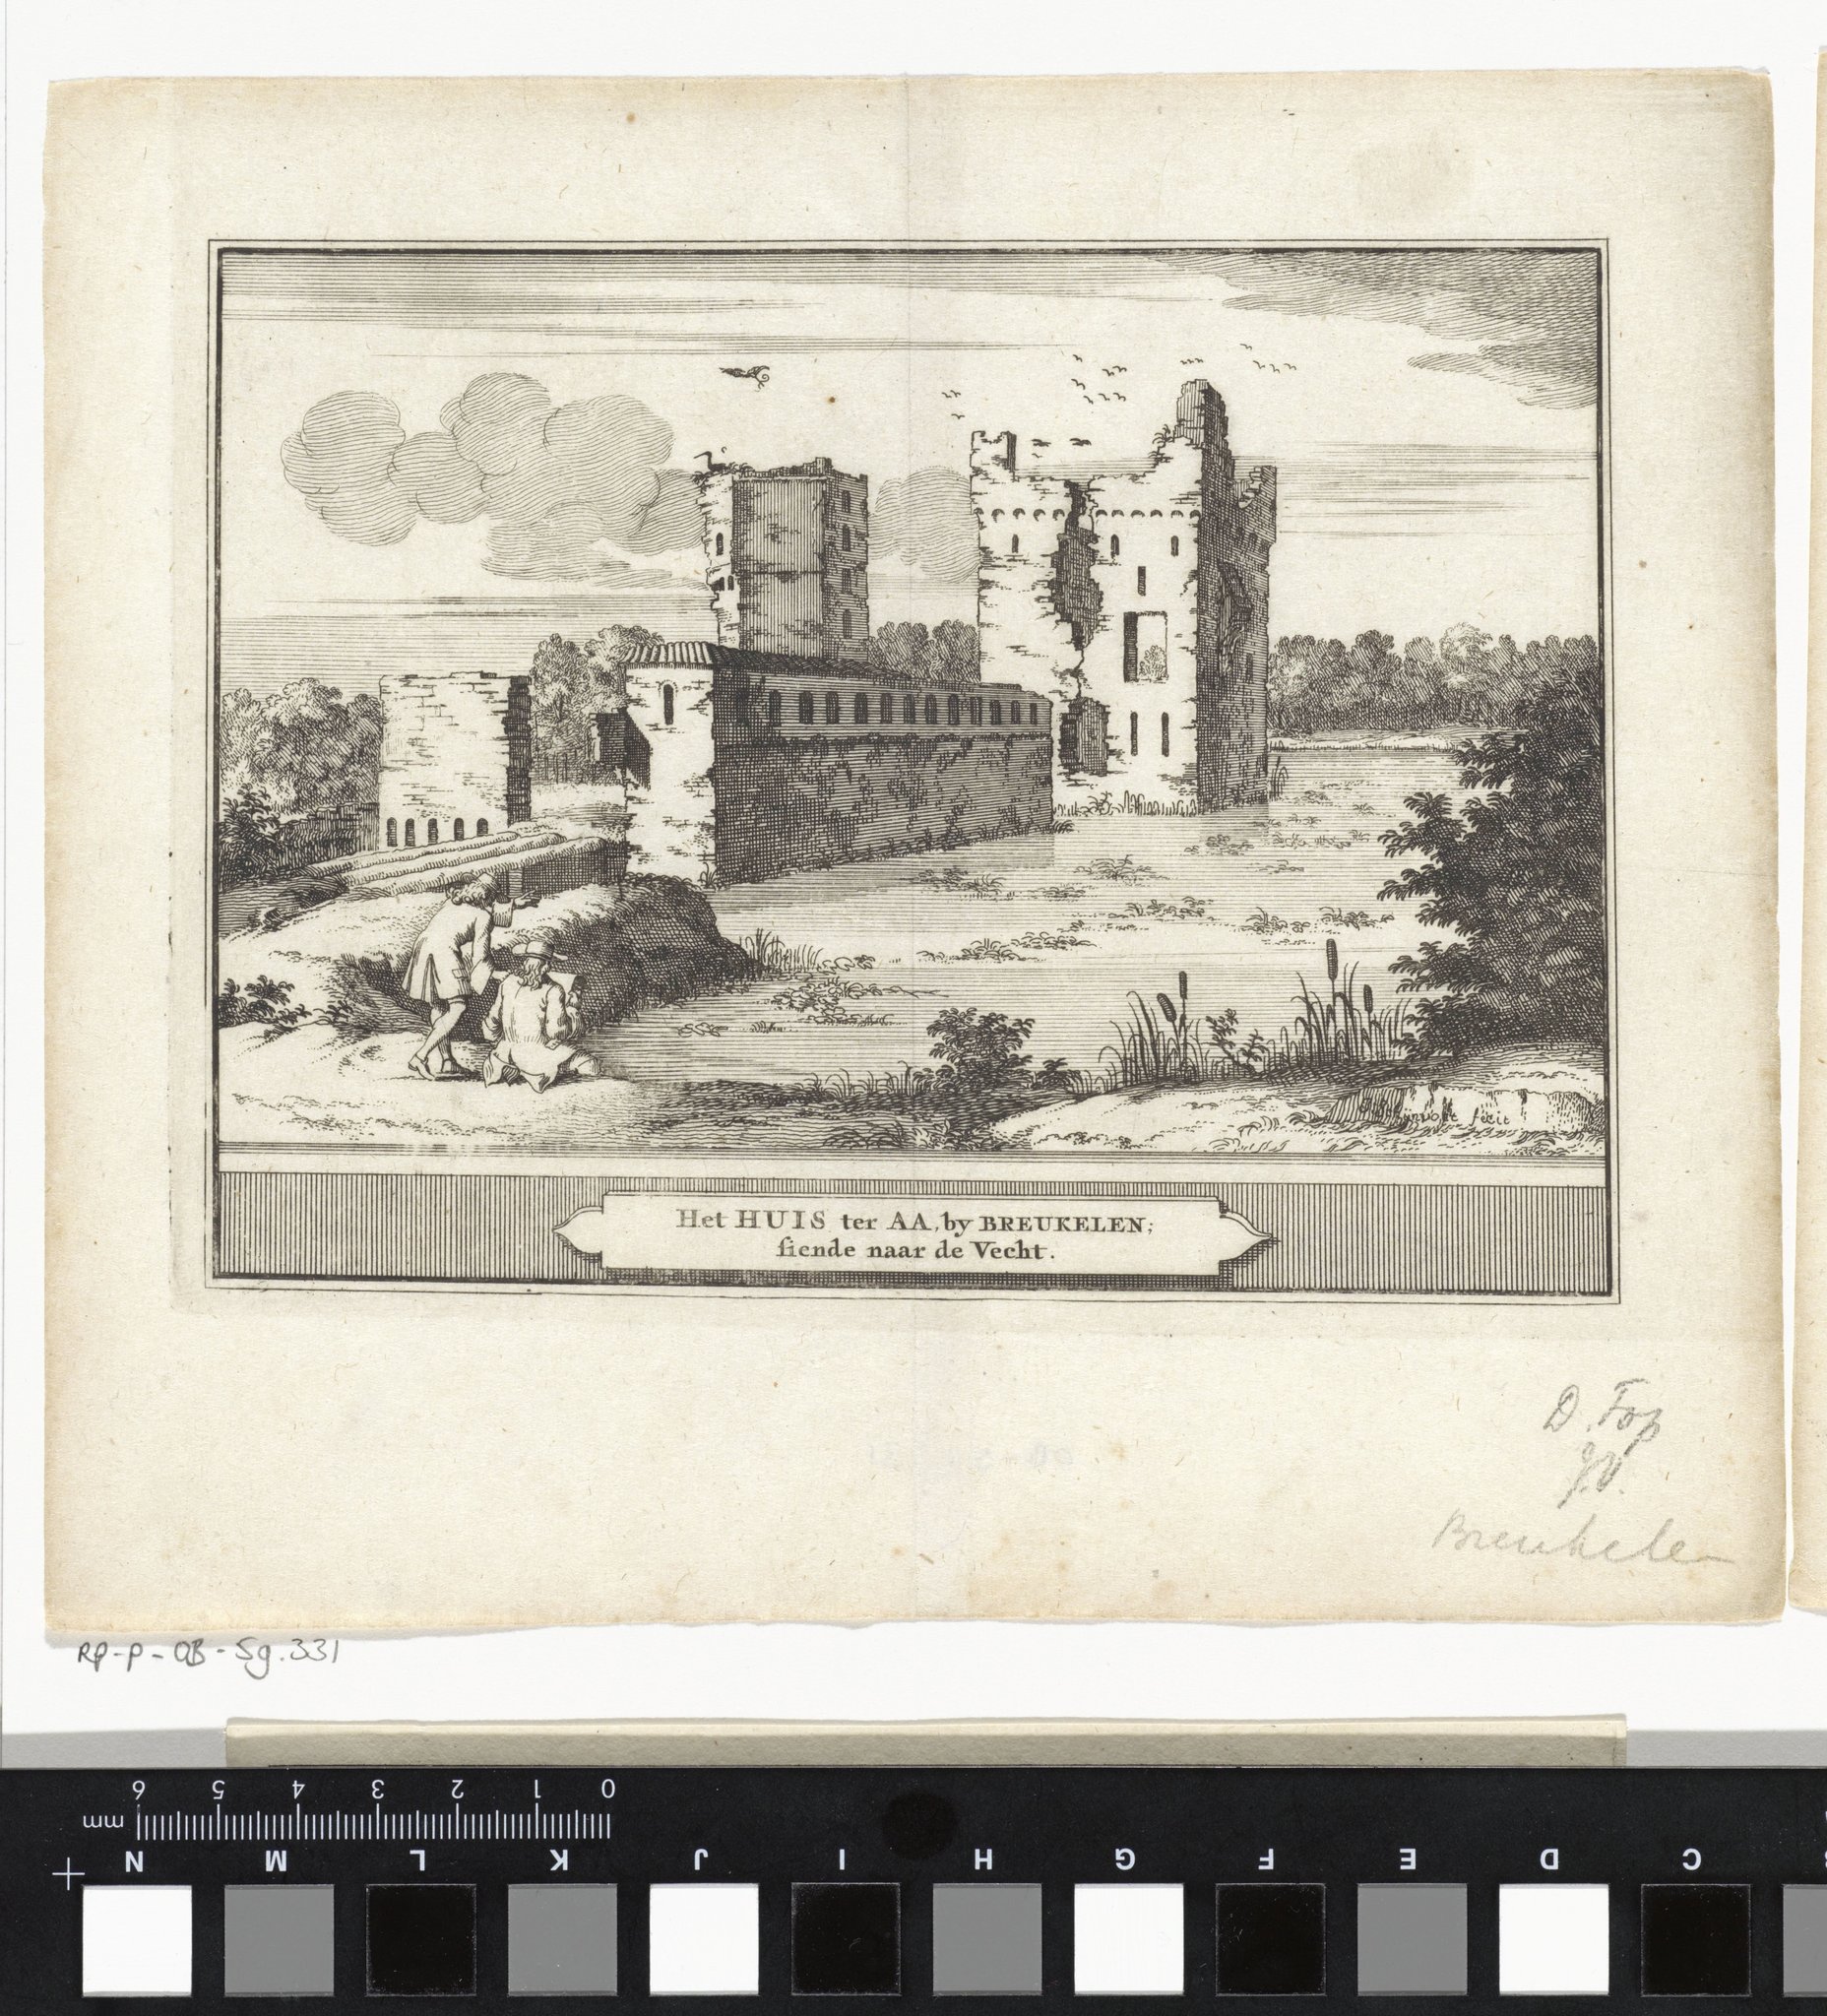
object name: print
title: Het huis ter Aa, by Breukelen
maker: jacobus schijnvoet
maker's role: draughtsman, print maker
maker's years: 1685-1743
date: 1711-1774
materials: paper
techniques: etching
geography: amsterdam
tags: castle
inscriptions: collector's mark: Lugt 2228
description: Prent als illustratie opgenomen in: Smids, Ludolph. Schatkamer der Nederlandsse[!] oudheden; of Woordenboek, behelsende Nederlands steden, Amsterdam: Pieter de Coup, 1711. Verscheen tevens in de heruitgave van voorgenoemd werk in 1737 en 1774. In 1721 verscheen er een uitgave met alleen de prenten: Nederlandsche oudheden, bestaande in zestig verbeeldingen (...) gelegen in Holland, 't Sticht van Utrecht en Gelderland enz. Amsterdam: Hendrik Bosch, 1721.